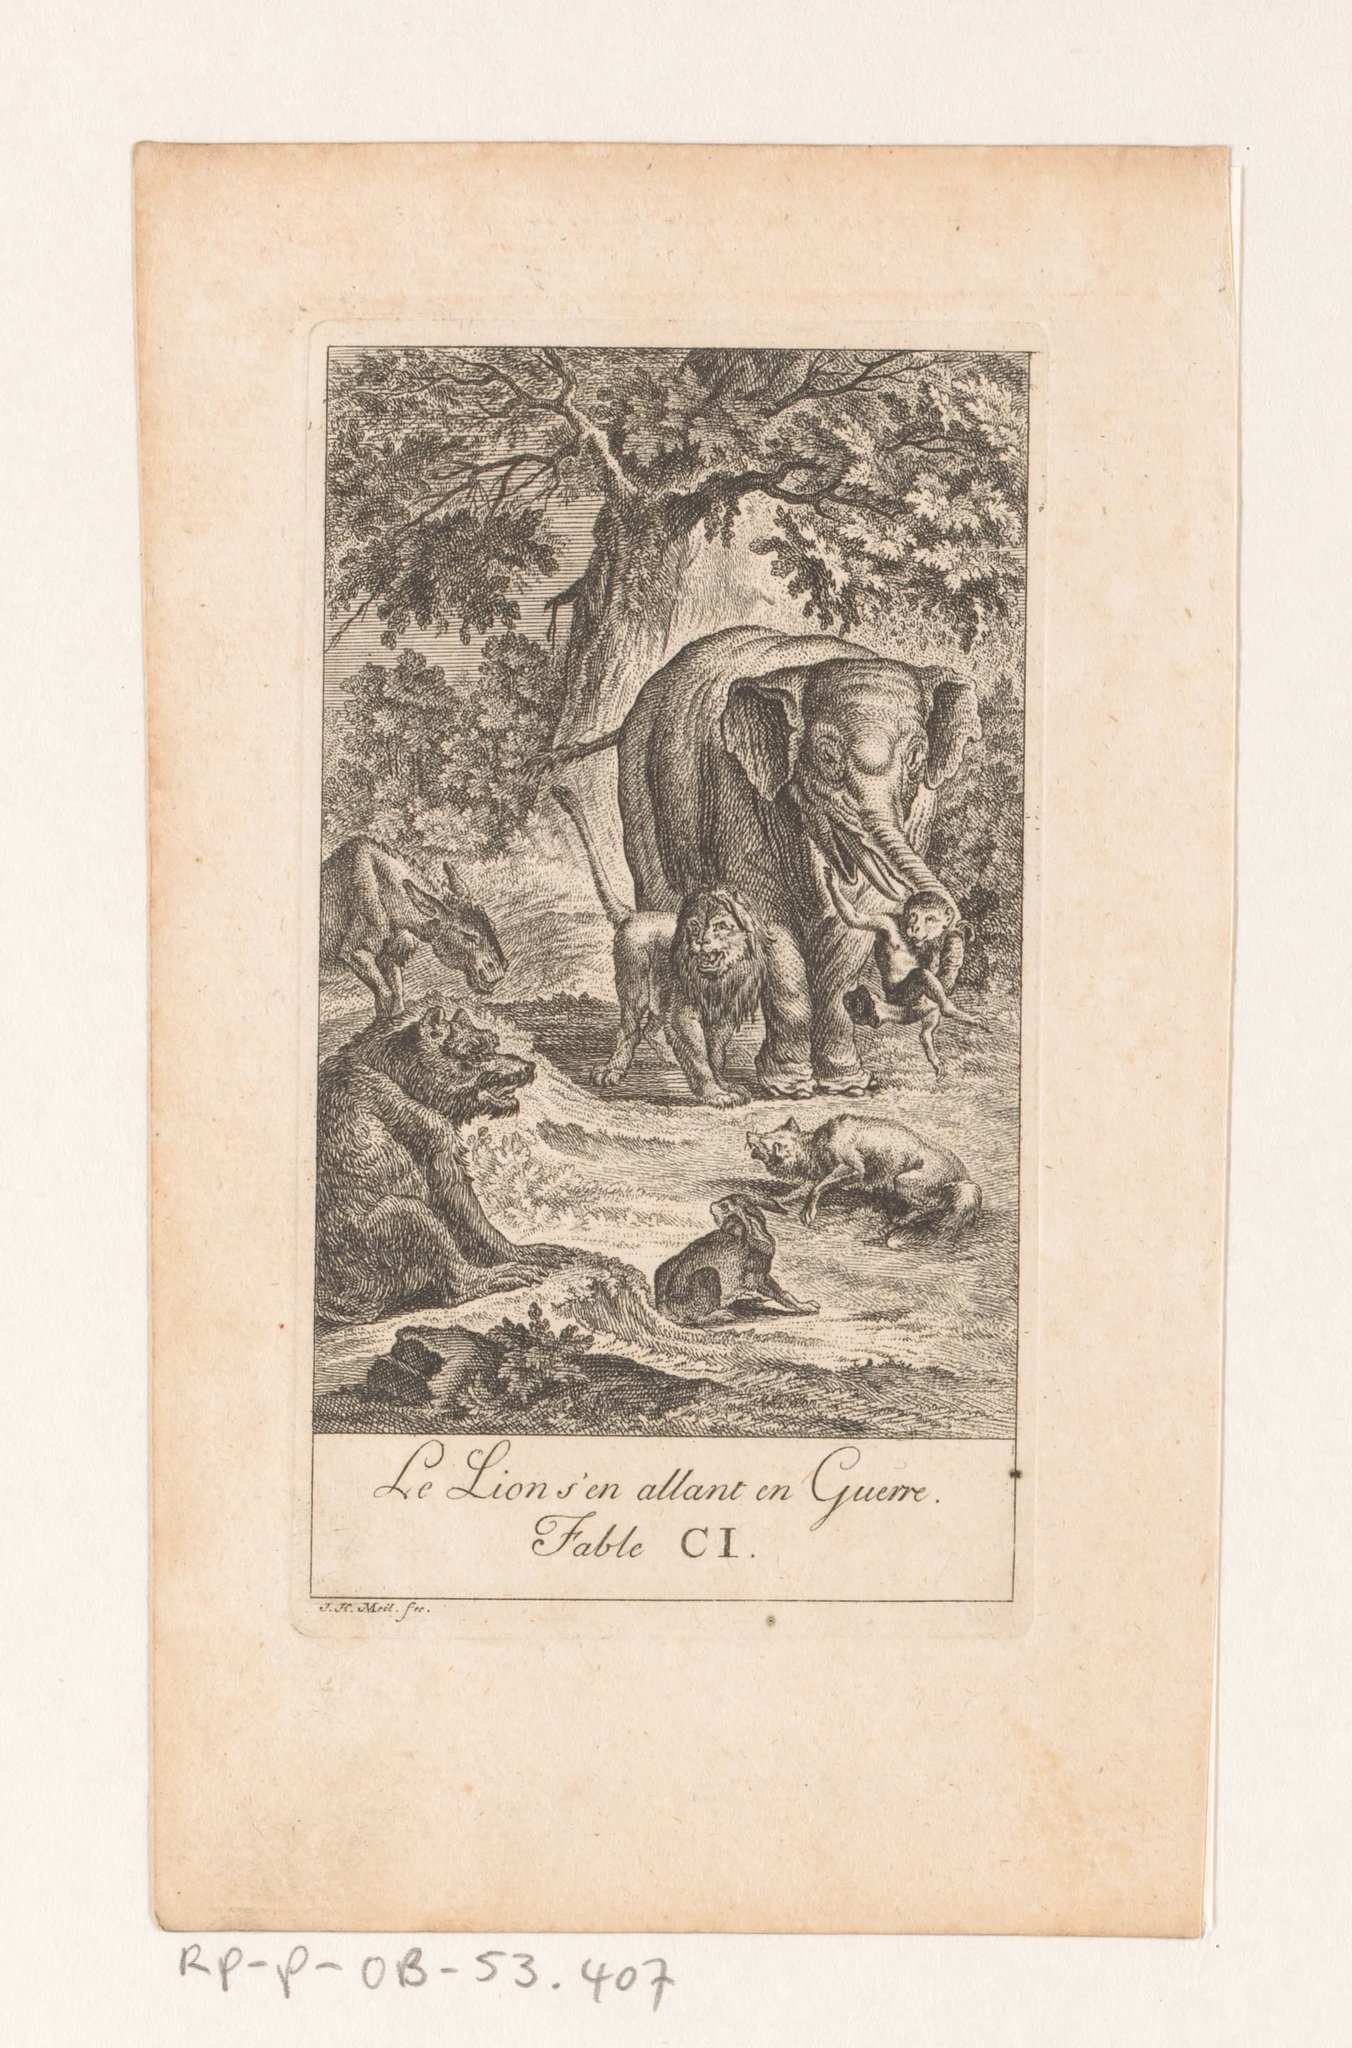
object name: book illustration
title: Le lion s'en allant en guerre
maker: johann heinrich meil (der ältere)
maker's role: print maker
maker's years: 1730-1820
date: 1758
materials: paper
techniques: etching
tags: fables of lafontaine : use 85(...), animals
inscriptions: collector's mark: Lugt 2228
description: Illustratie uit: Fontaine, J. de la. Fables choisies, mises en vers. Dl. 2. Dresden & Leipzig: George Conrad Walther, 1758.